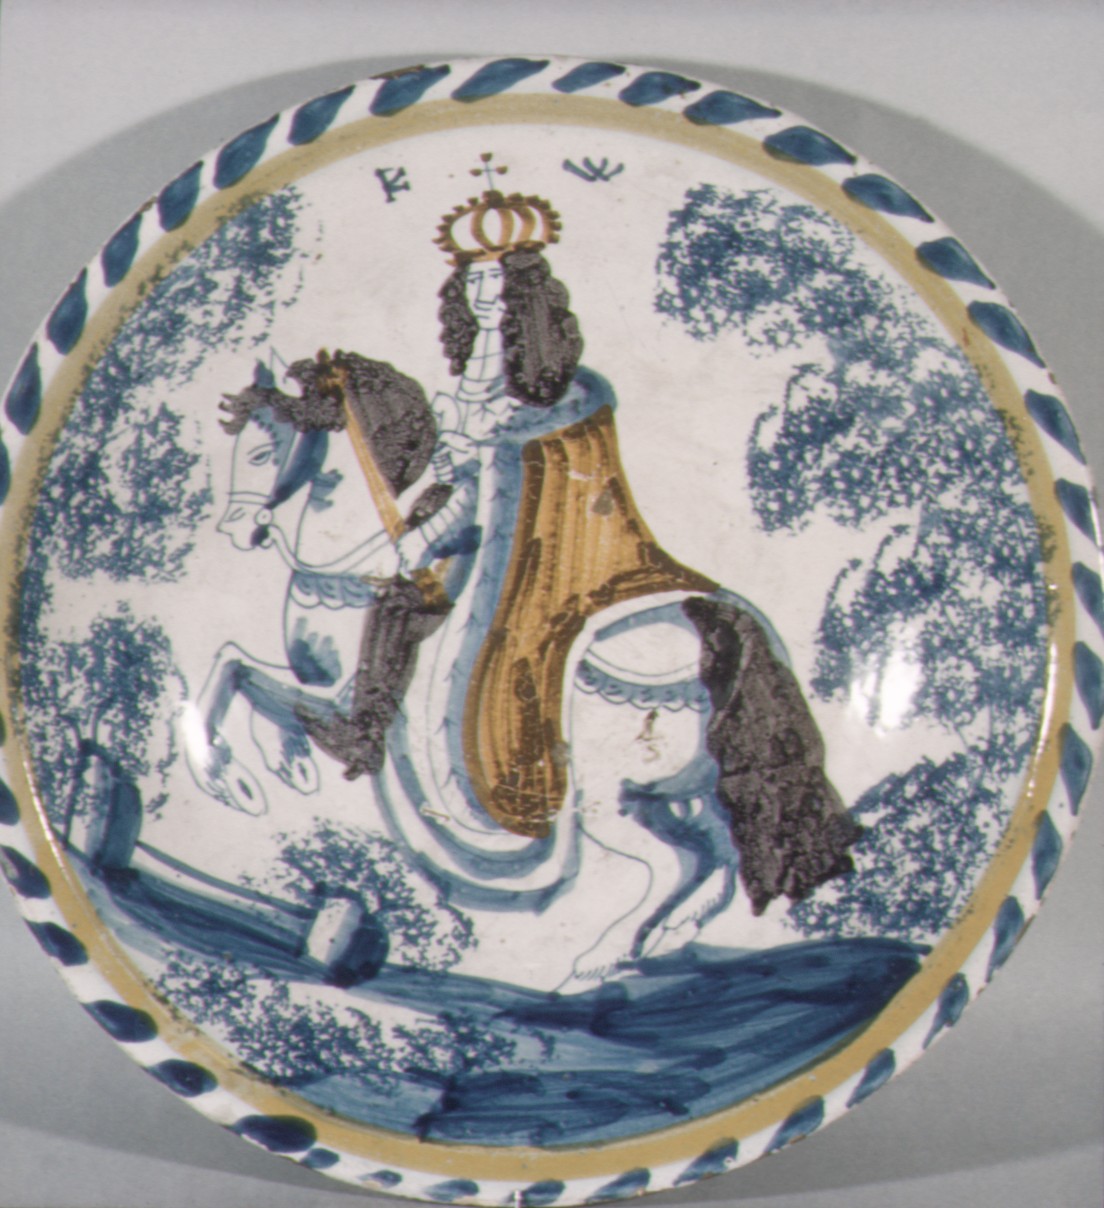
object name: dish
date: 1700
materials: earthenware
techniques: glazing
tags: men,horses